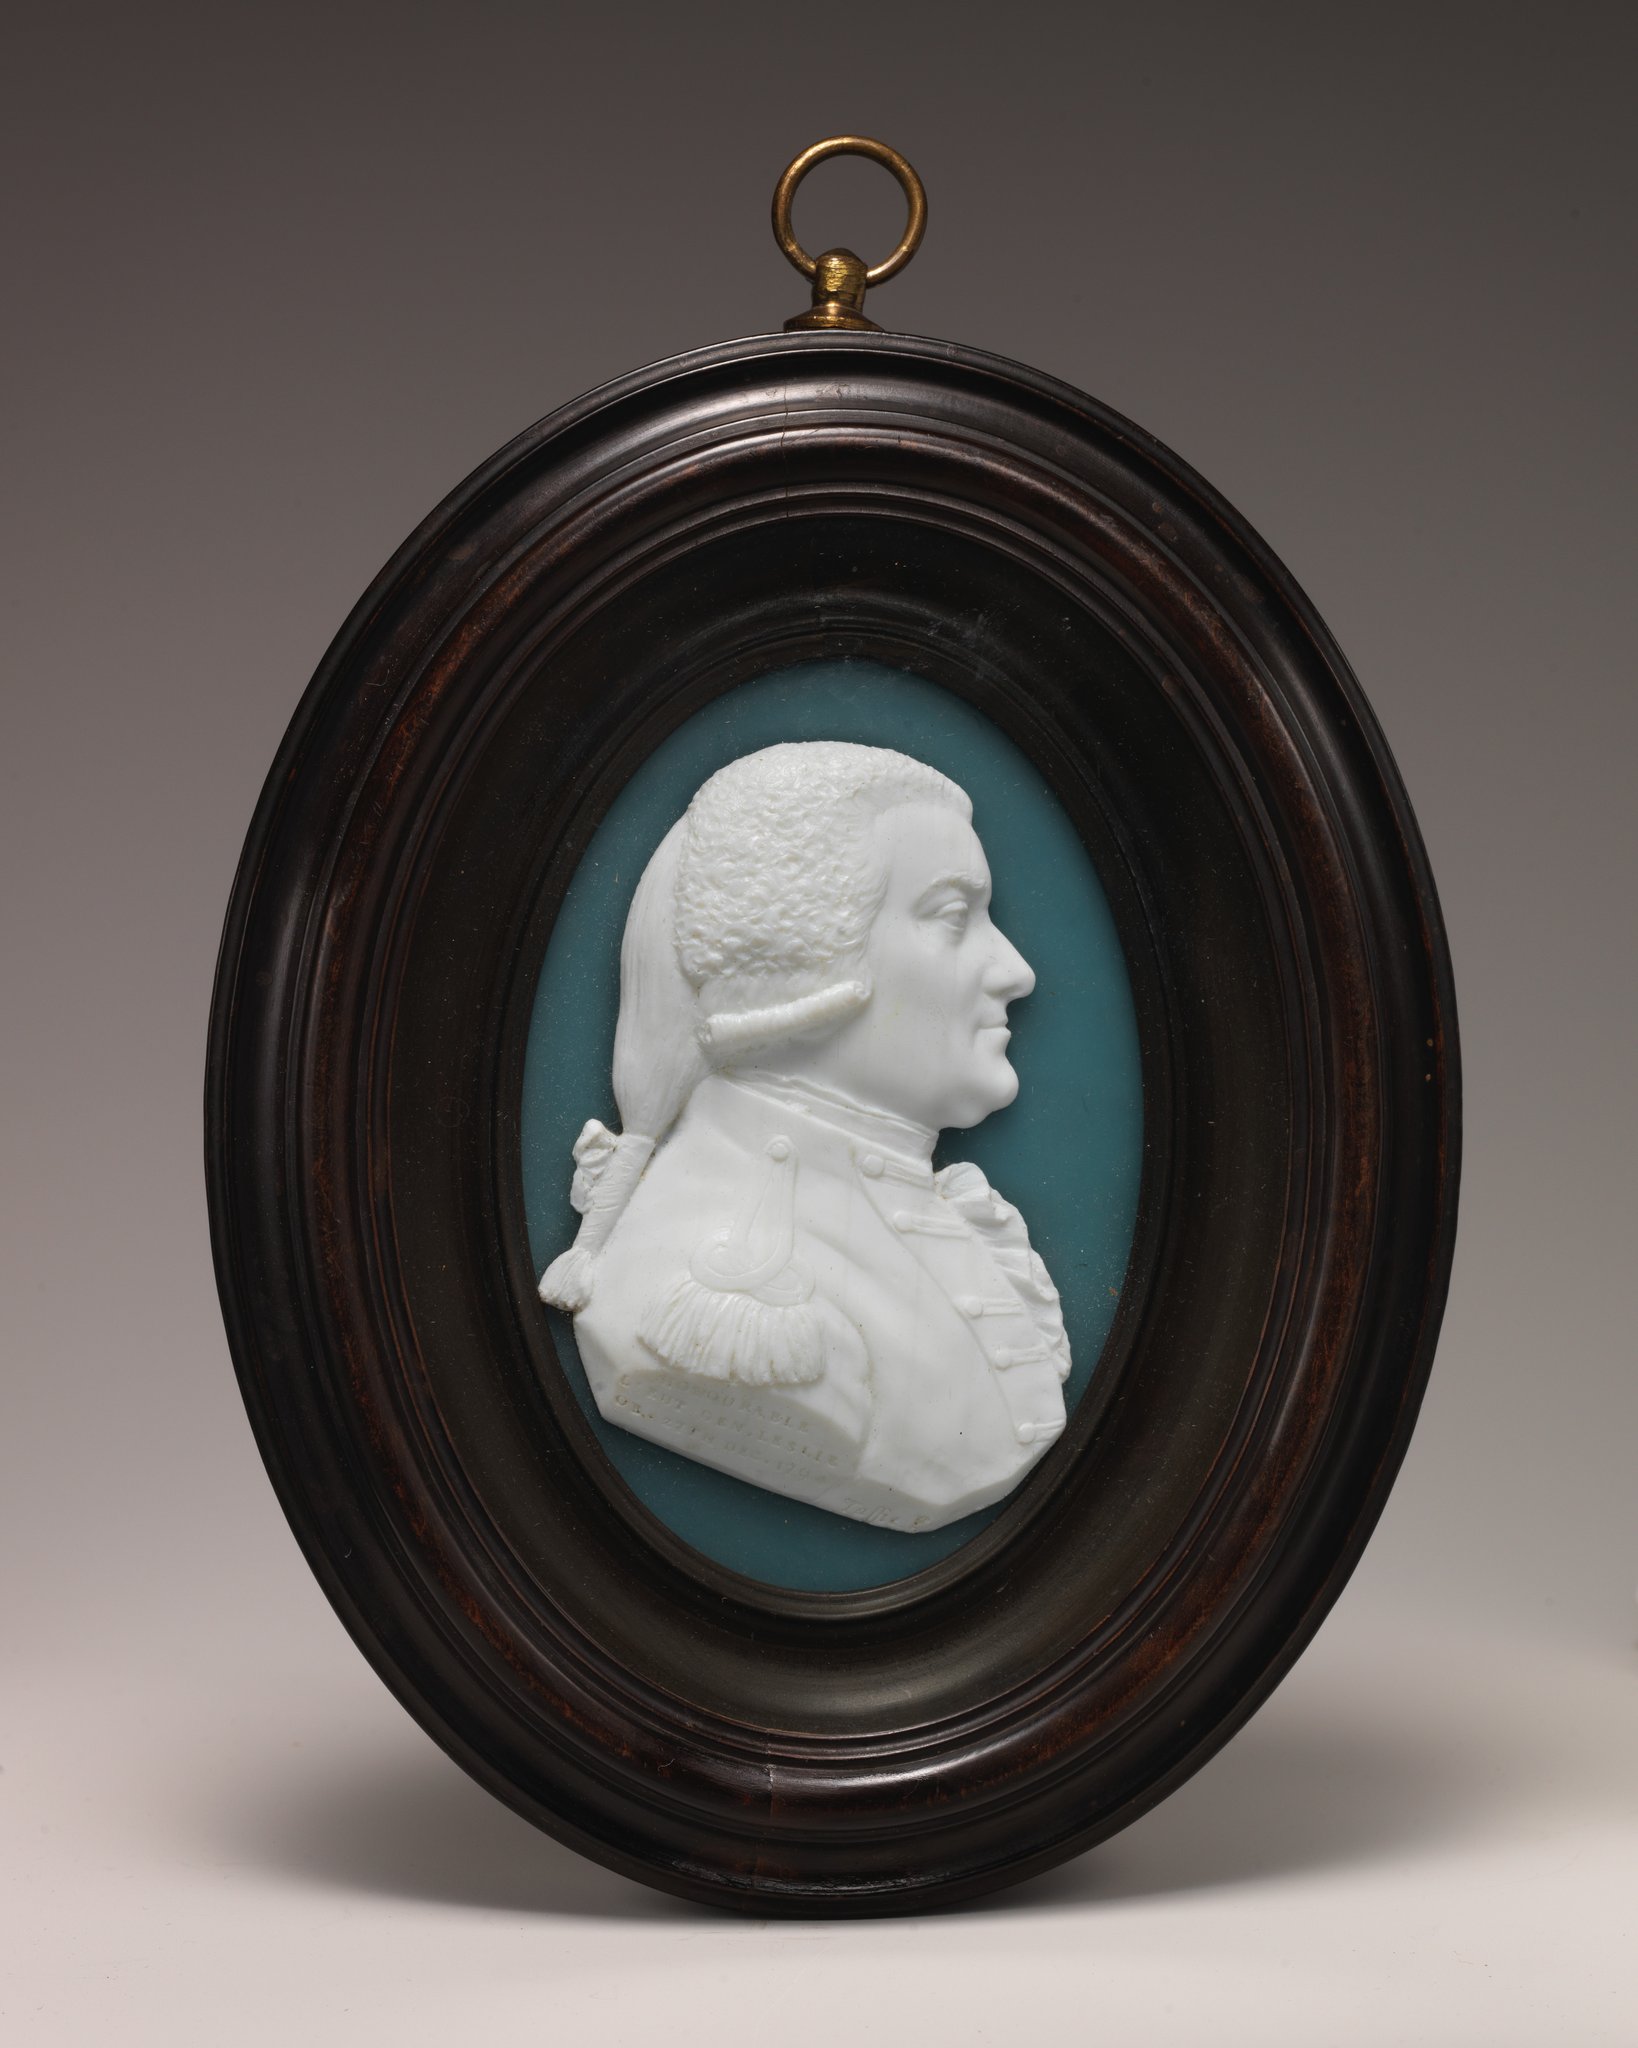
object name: memorial medallion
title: The Hon. Lieutenant-General Alexander Leslie (1731–1794)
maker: james tassie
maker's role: artist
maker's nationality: british, scottish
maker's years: 1735-1799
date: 1794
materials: glass, paste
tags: men,profiles,generals